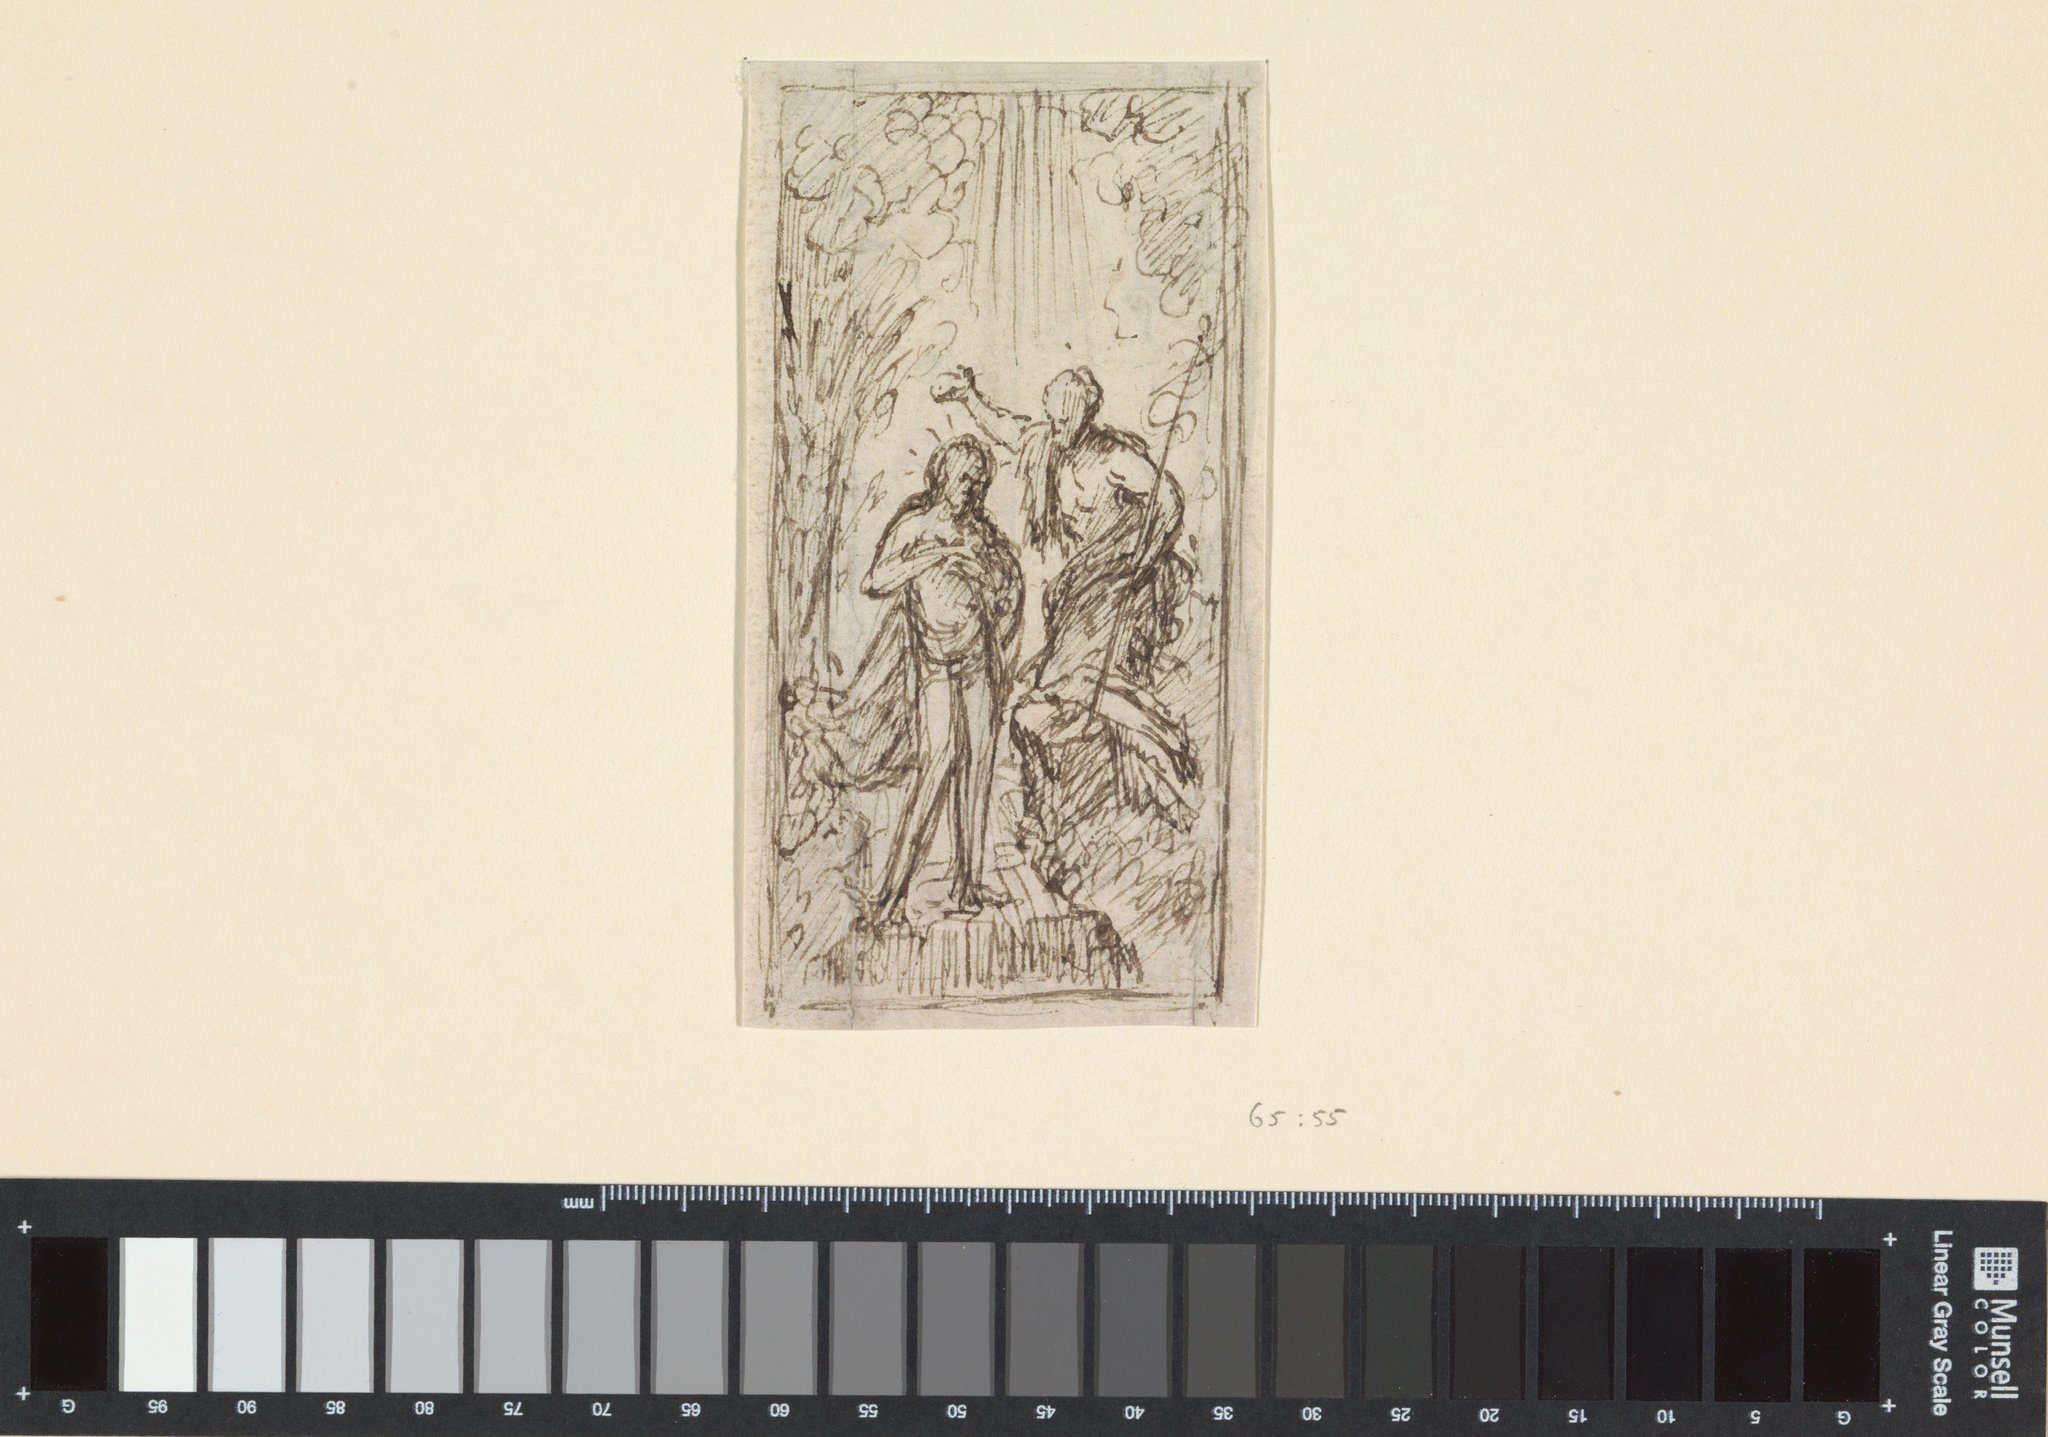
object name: ornamenttekening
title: Doop van Christus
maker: Anonymous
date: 1600-1800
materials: ink, paper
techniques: pen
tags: baptism of christ in the river jordan: john the baptist pouring out water on christ's head: the holy ghost descends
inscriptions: collector's mark: Lugt 2228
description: De doop van Christus in de rivier de Jordaan. Johannes de Doper (rechts) giet water over Christus' hoofd.